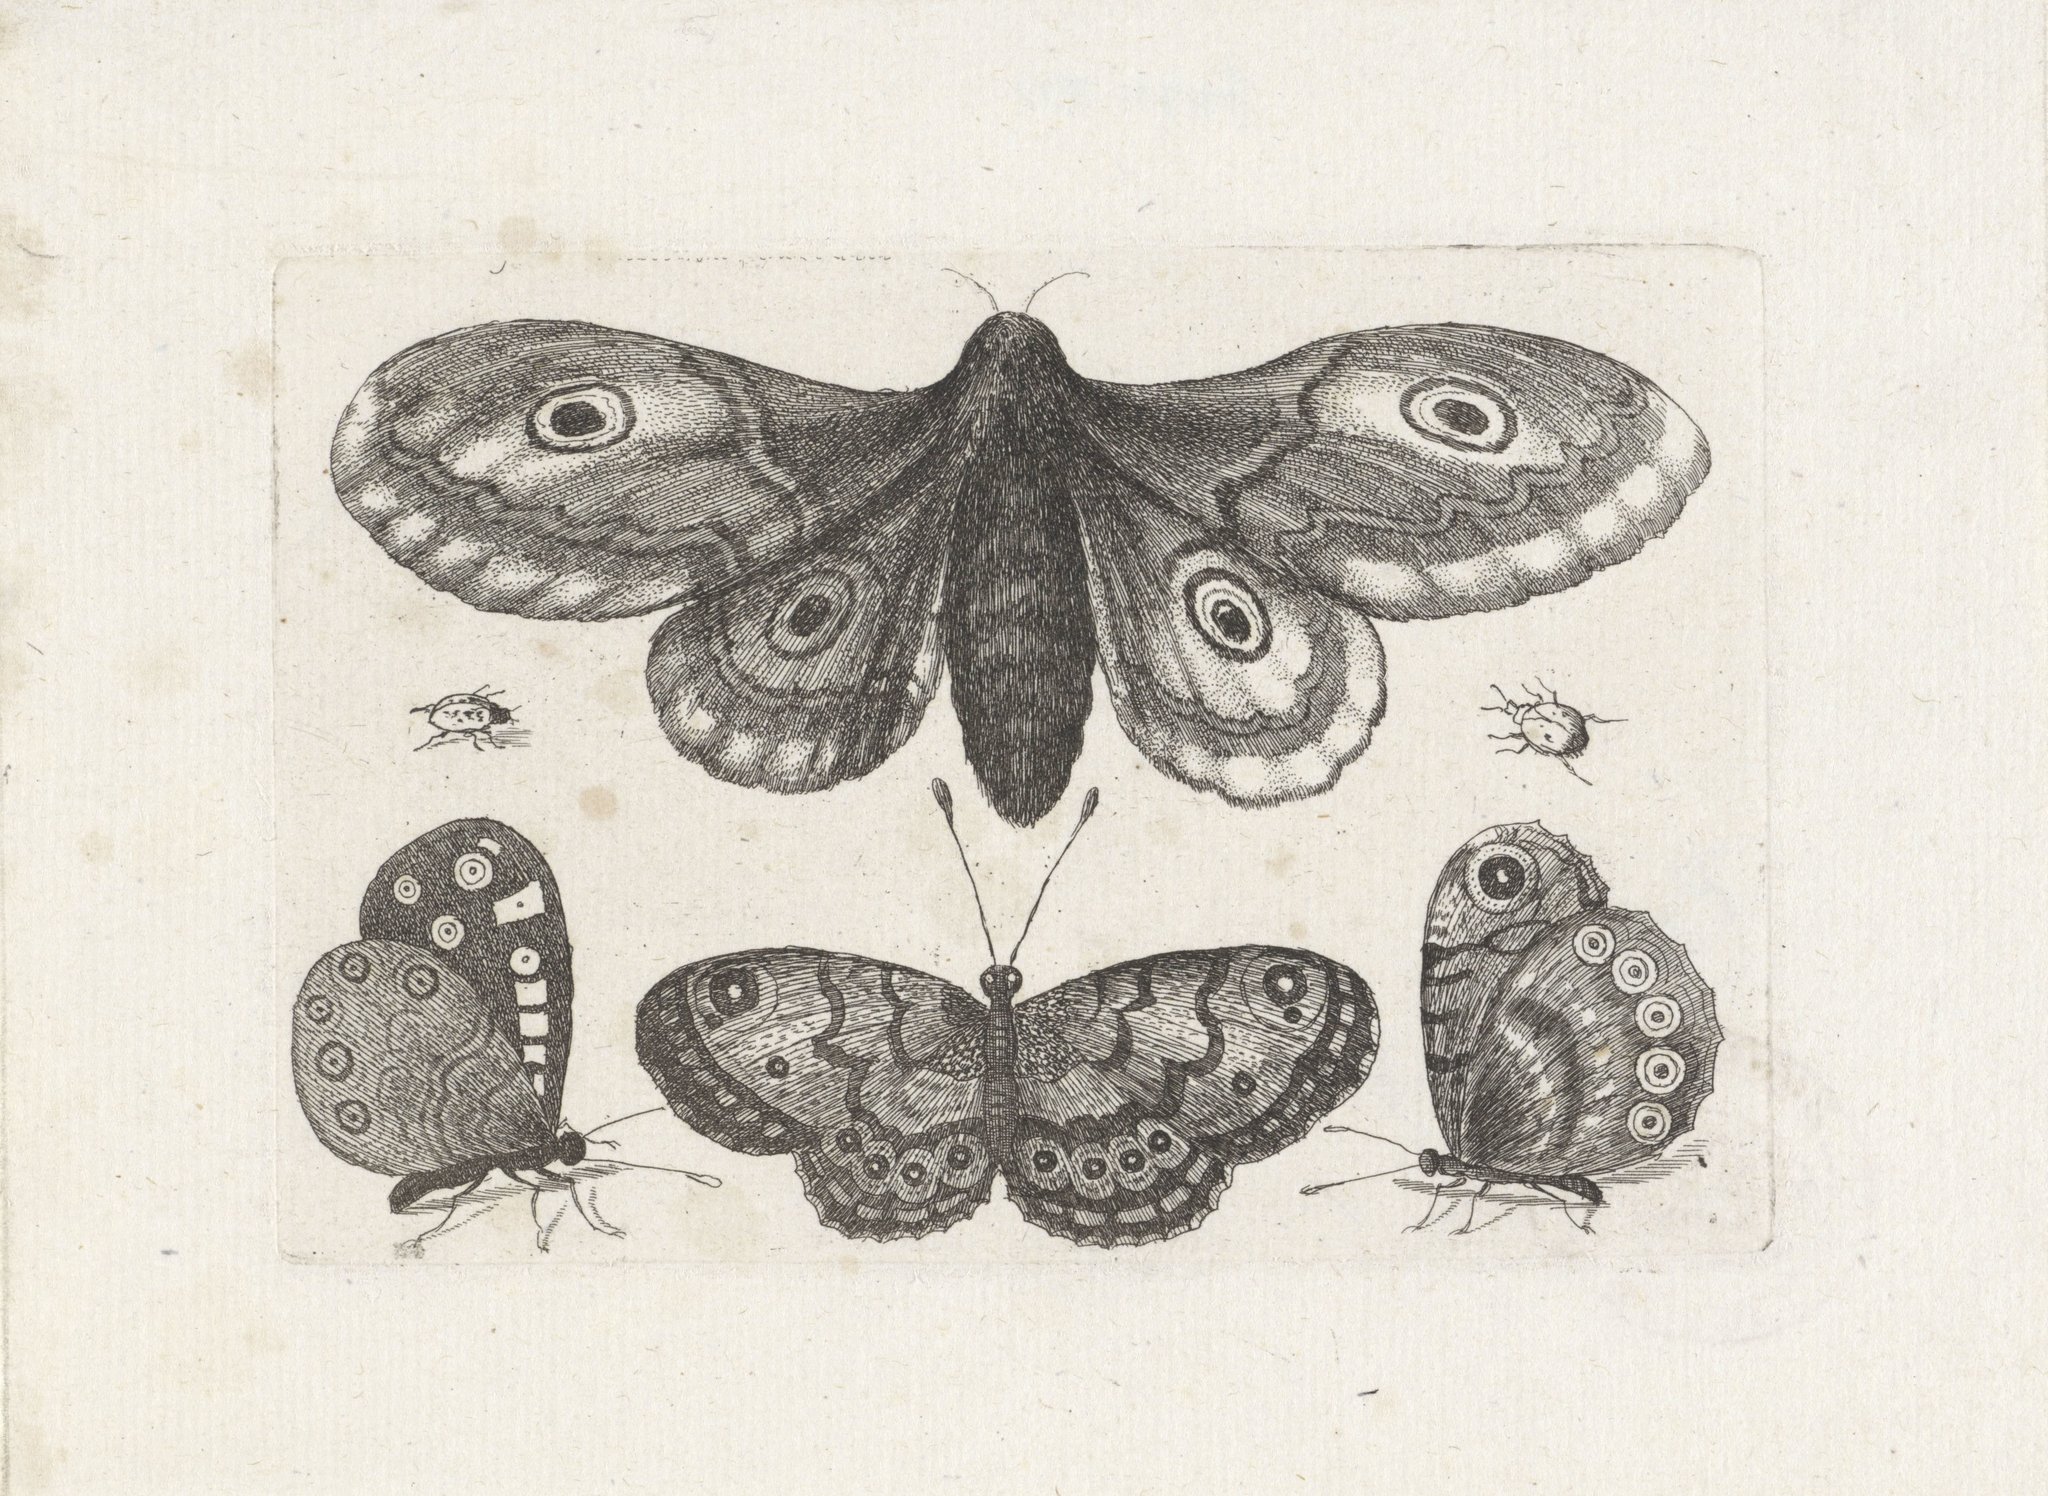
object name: print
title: Insecten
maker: wenceslaus hollar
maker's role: draughtsman, print maker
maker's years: 1607-1677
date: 1646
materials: paper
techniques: etching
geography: antwerp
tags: insects: moth, insects: butterfly, insects: beetle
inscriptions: collector's mark: Lugt 240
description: Prent maakt deel uit van de twaalfdelige serie (incl. titelprent) met verschillende insecten: "Muscarum Scarabeorum".